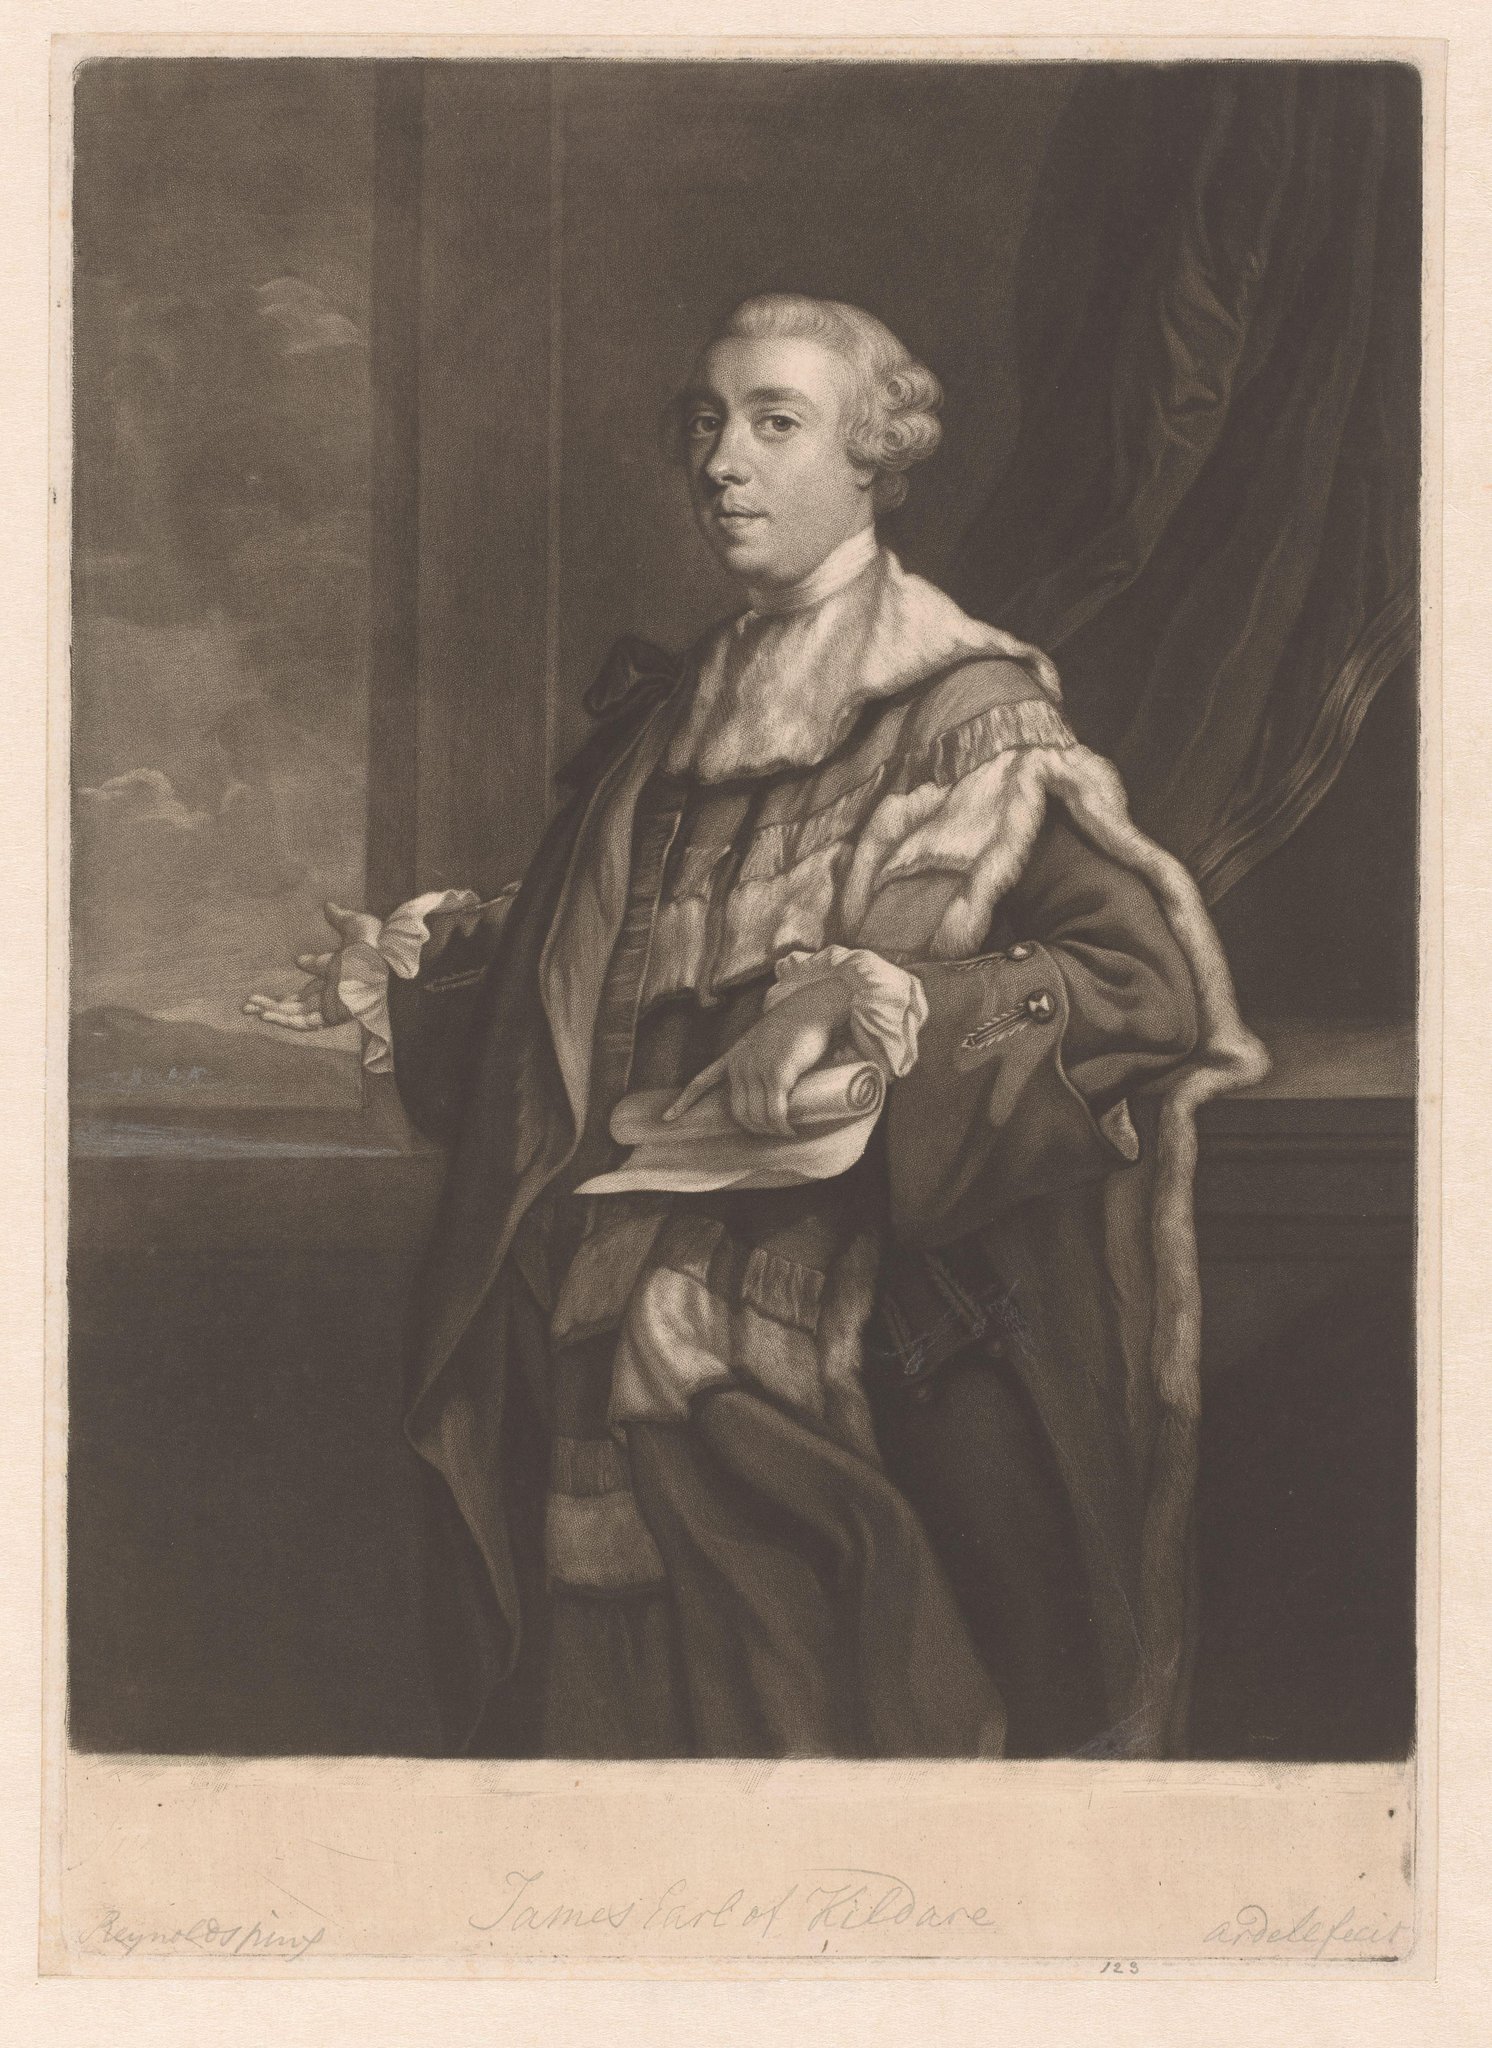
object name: print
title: Portret van James FitzGerald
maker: james mcardell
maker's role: print maker, publisher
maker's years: 1728-1765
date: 1754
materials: paint, paper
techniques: brush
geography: london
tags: politician, historical persons, politician, e.g. party leader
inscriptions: collector's mark: Lugt 240, inscription: ‘Reynolds Pinx James Earl of Kildare Ardell fecit’